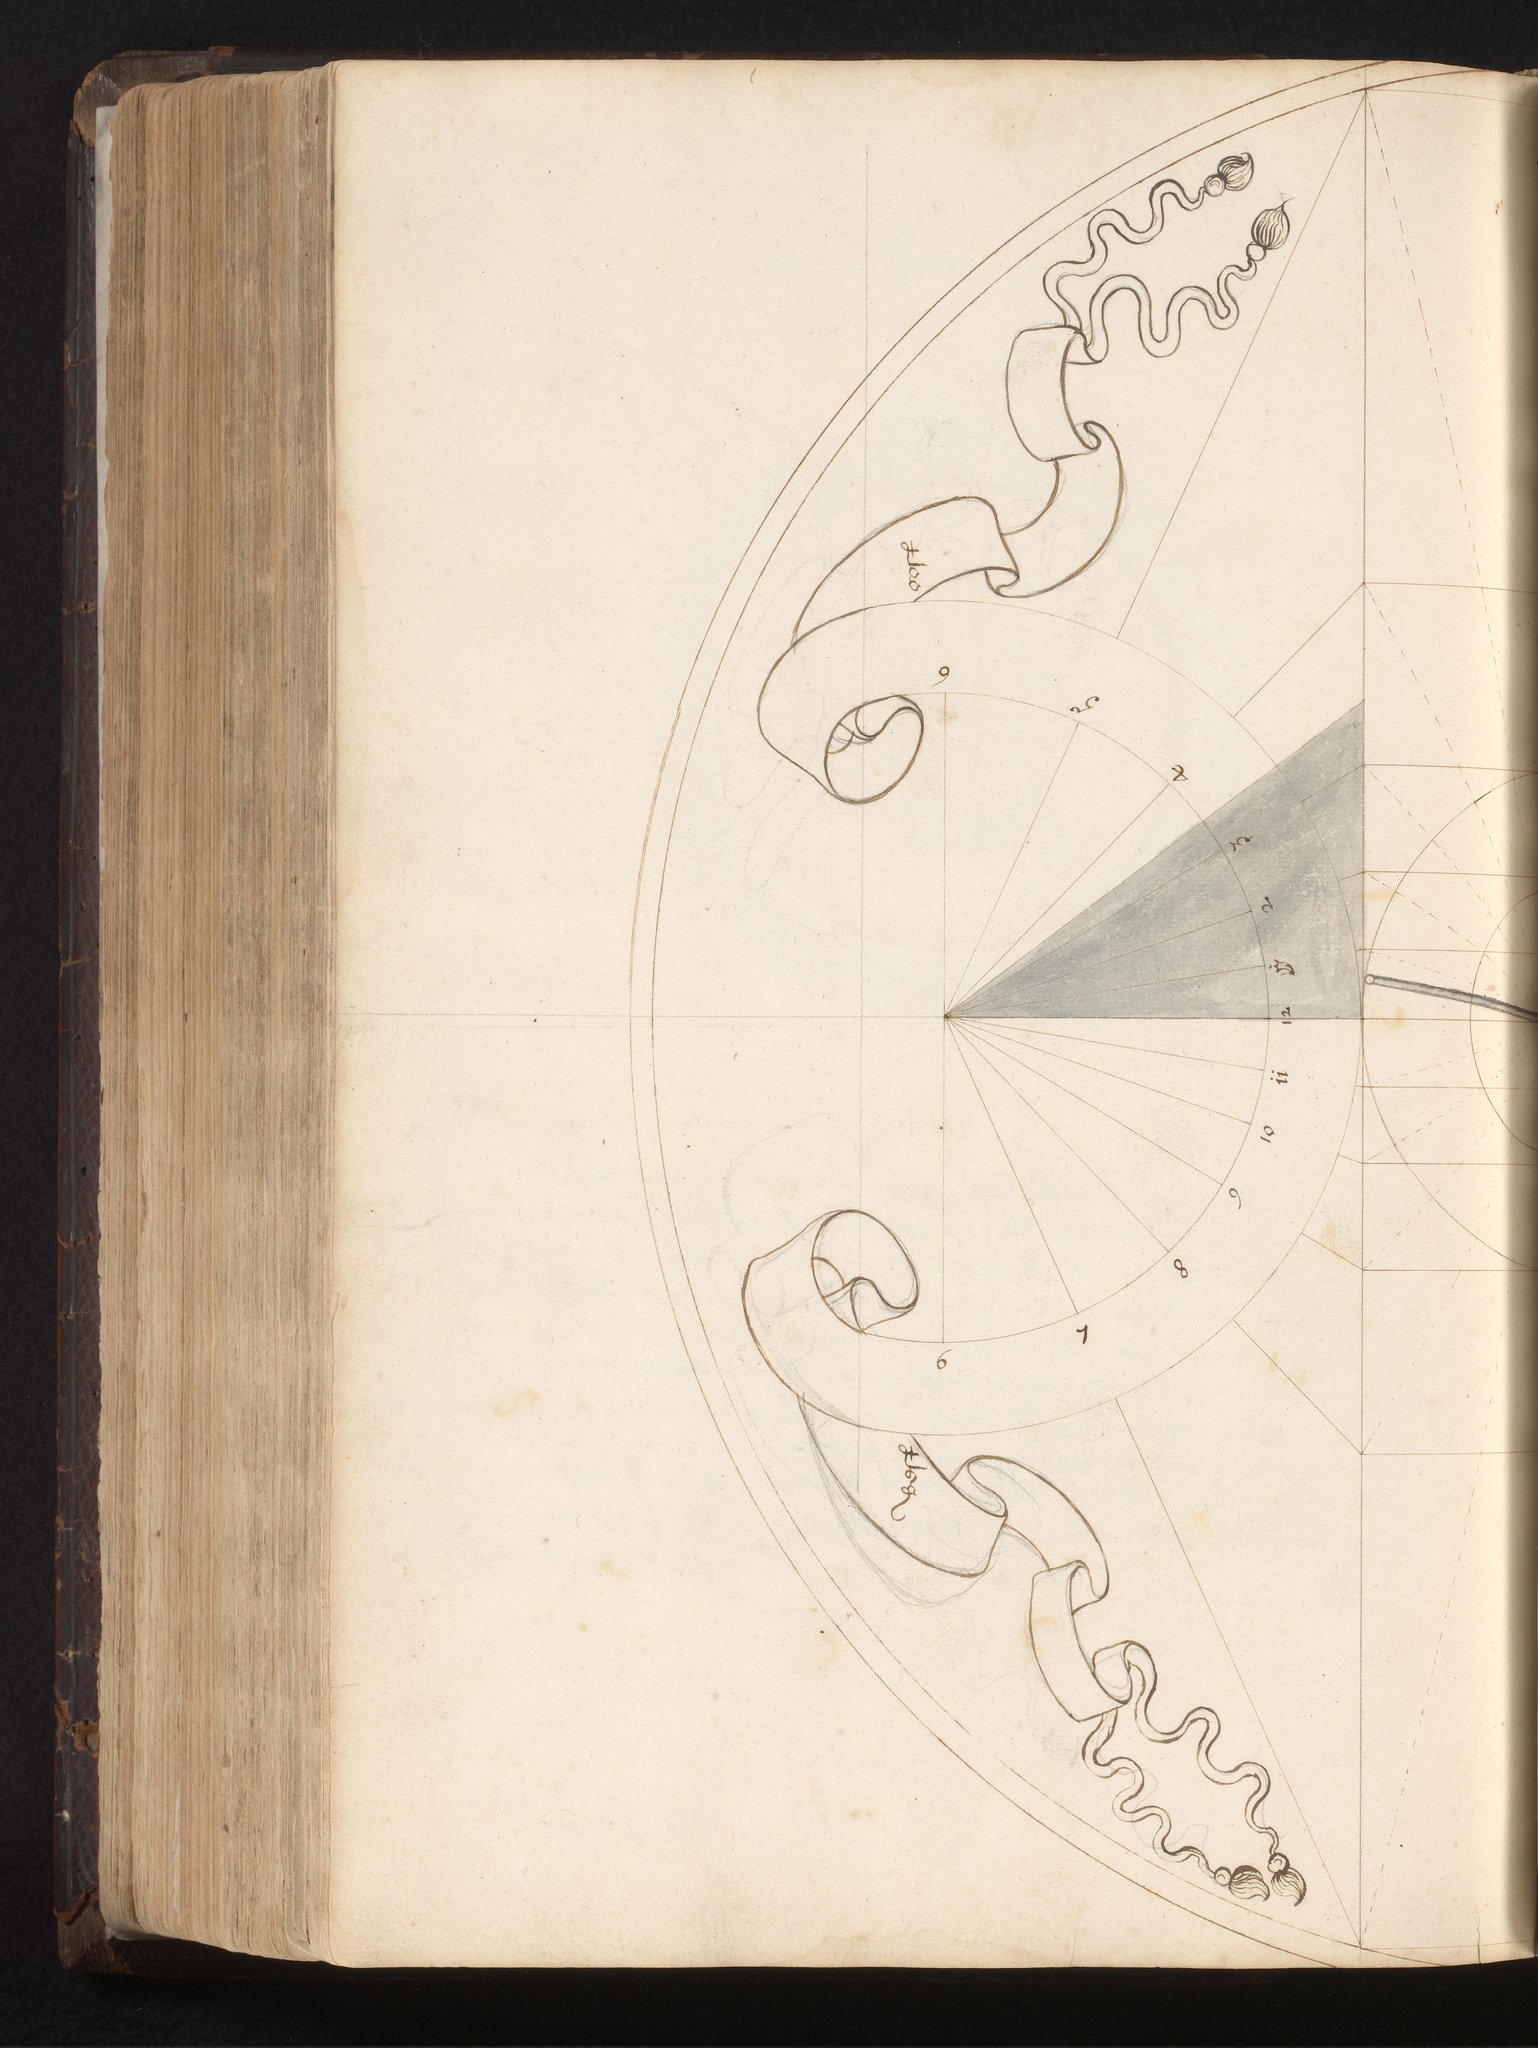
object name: drawing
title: Ontwerp voor een zonnewijzer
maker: Anonymous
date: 1650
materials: ink, paper, pencil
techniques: brush, pen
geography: low countries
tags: sundial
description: Tekening beslaat 32(V) en 33(R). Tekening maakt deel uit van een album.